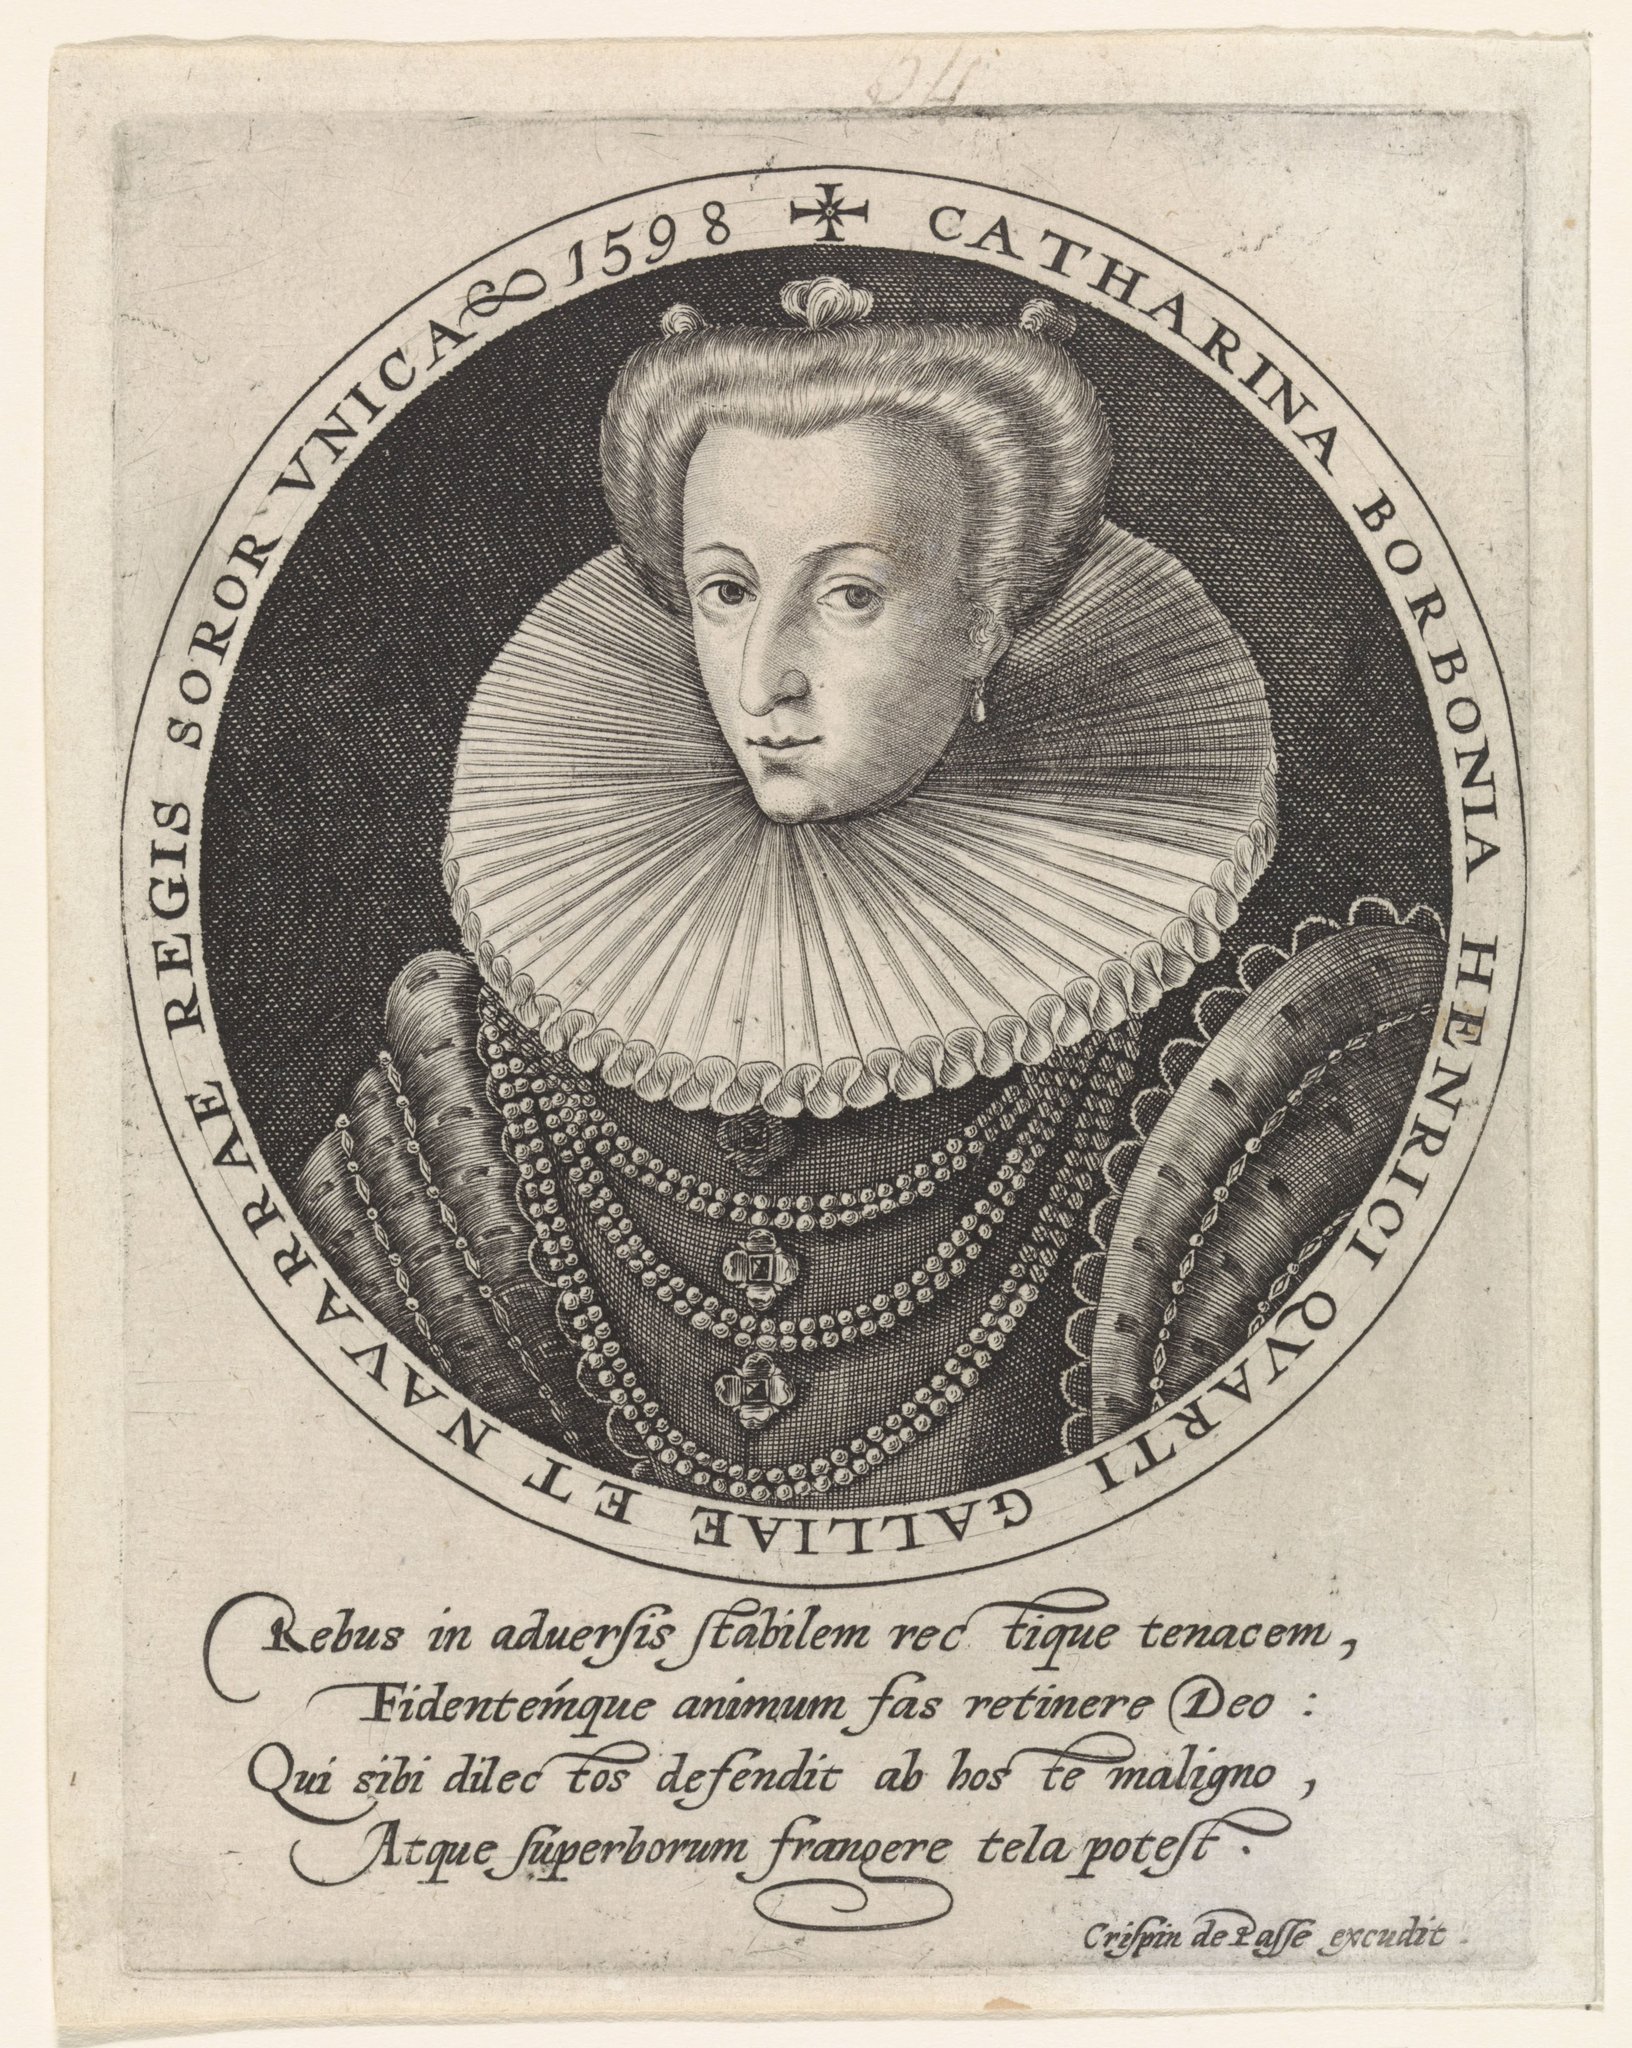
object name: print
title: Portret van Catharina van Bourbon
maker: crispijn van de passe (i)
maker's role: draughtsman, print maker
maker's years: 1564-1637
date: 1598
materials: paper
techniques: engraving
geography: cologne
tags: catharina de bourbon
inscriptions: date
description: Portret van Catharina van Bourbon, zus van Hendrik IV van Frankrijk. In het randschrift van de omlijsting de naam en functie van de geportretteerde in het Latijn. In de marge een vierregelig lofdicht in het Latijn.